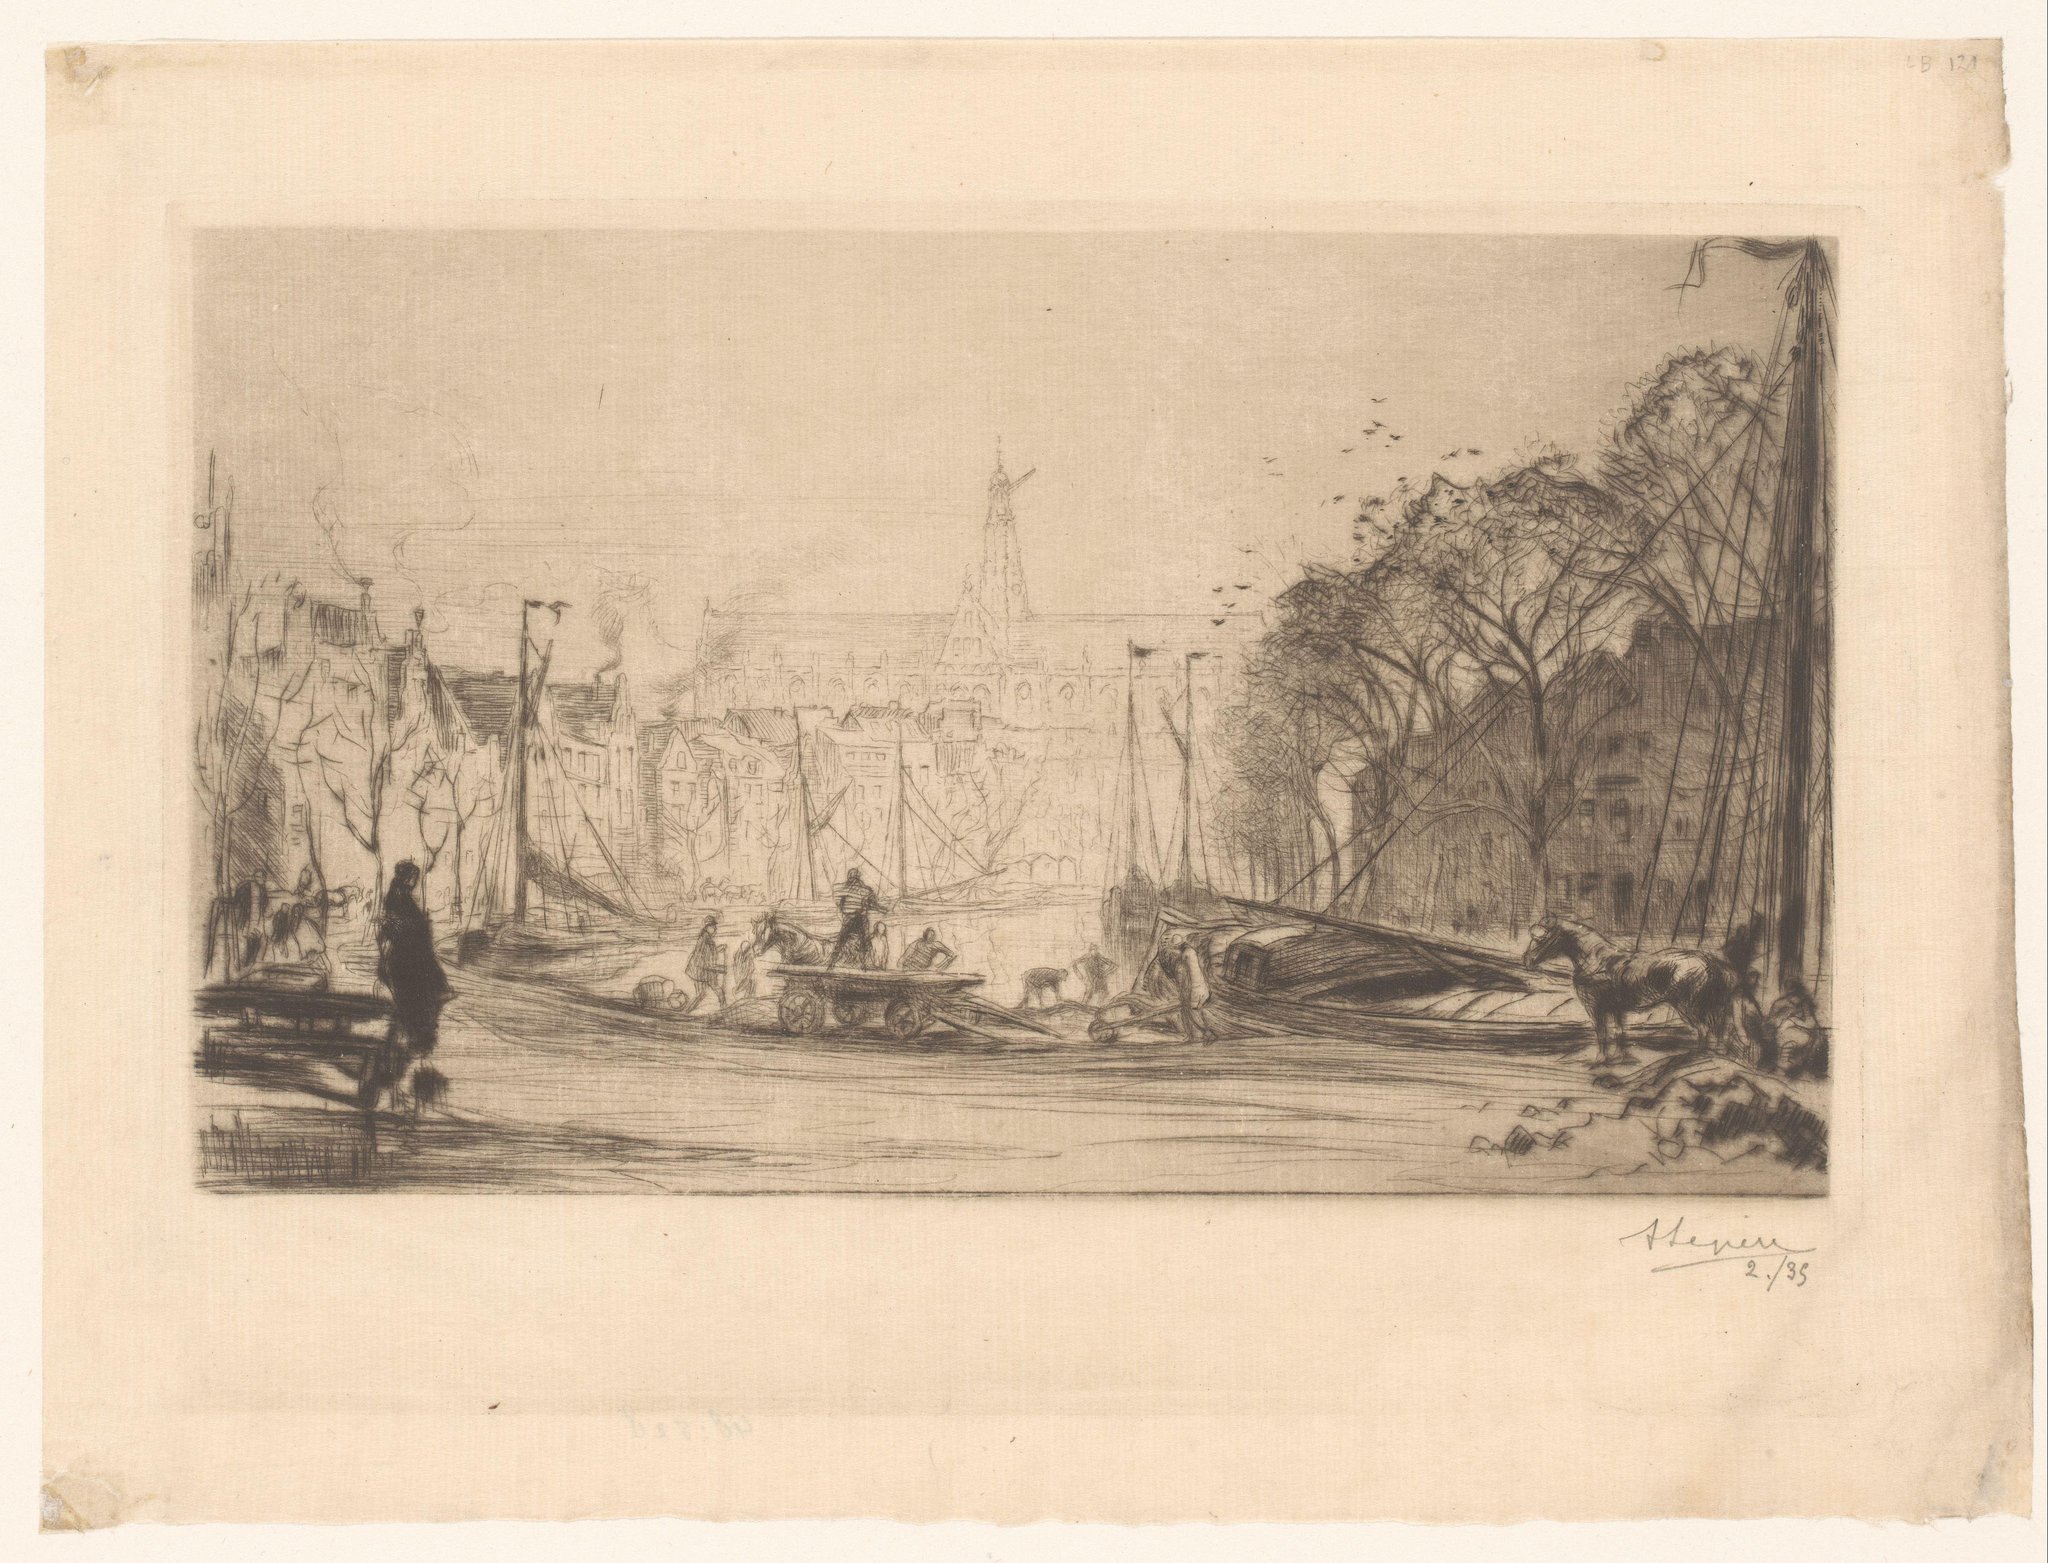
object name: print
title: Gezicht op het Spaarne en de Sint Bavo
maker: auguste lepère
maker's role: print maker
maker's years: 1849-1918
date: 1859-1918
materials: paper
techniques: drypoint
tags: city-view in general; 'veduta', wheelbarrow, boat propelled by man or animal